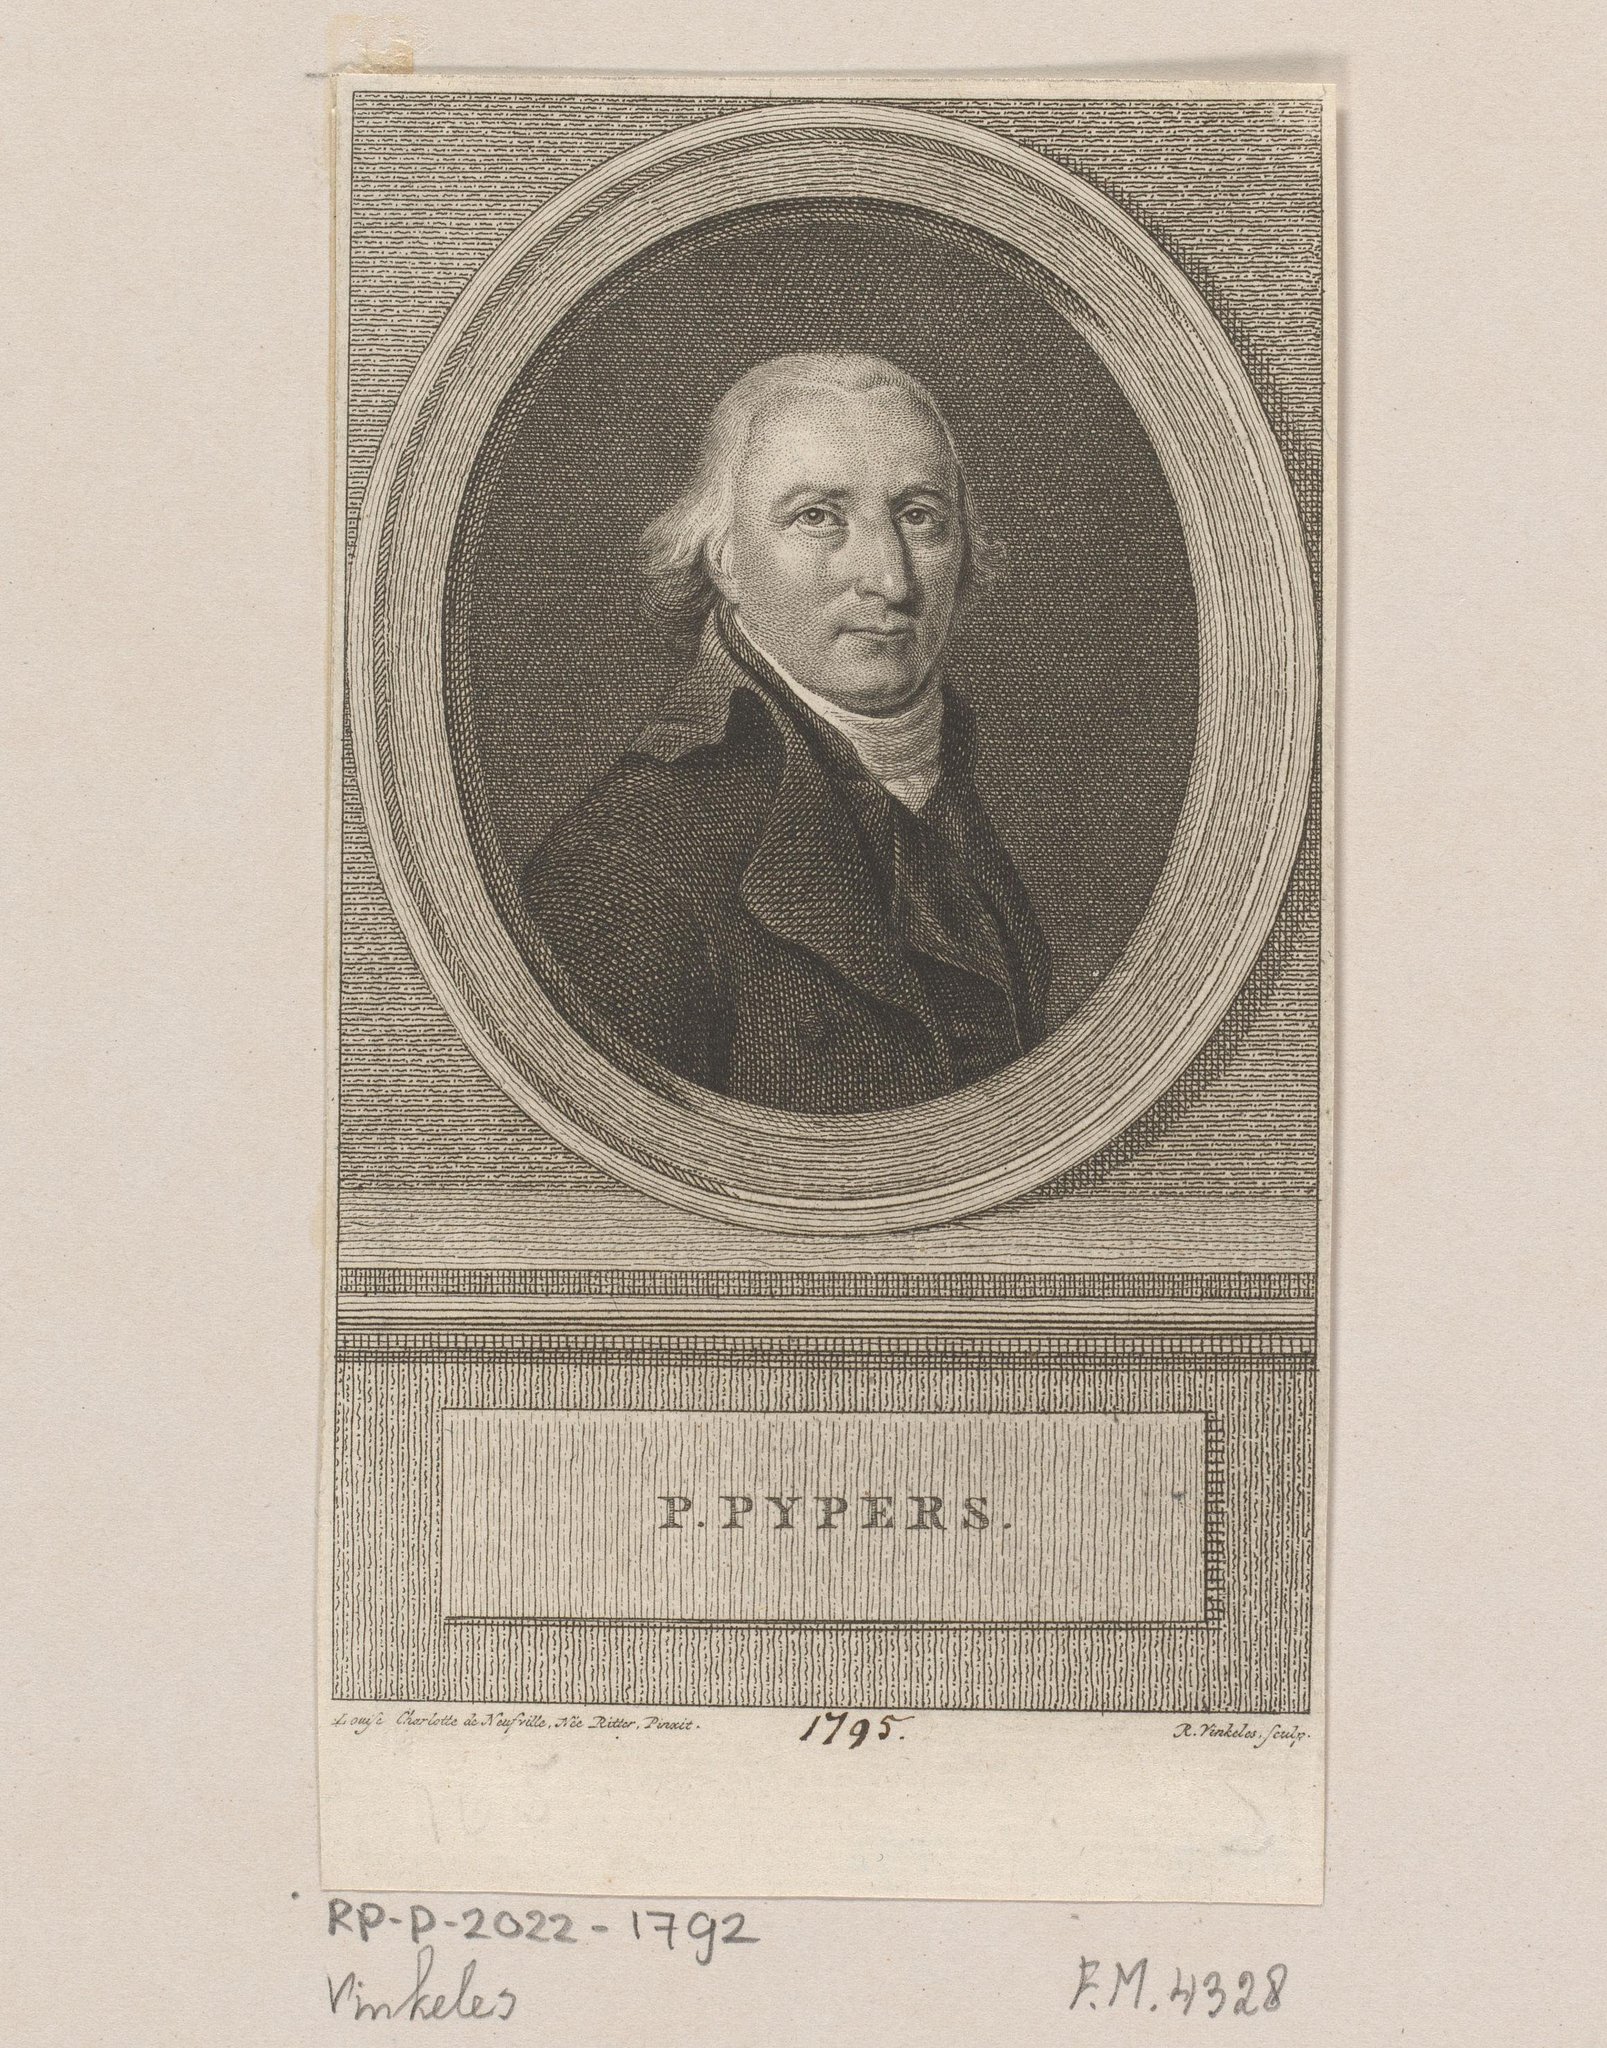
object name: print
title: Portret van Pieter Pypers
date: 1805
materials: paper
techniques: engraving, etching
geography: amsterdam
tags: pieter pypers, historical persons, portrait of a writer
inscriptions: number: ‘1795.’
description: Prent waarschijnlijk uit: Wagenaar, Jan. Vaderlandsche historie, (...) ten vervolge van Wagenaars Vaderlandsche historie. Amsterdam: Johannes Allart, dl. 34, 1805.